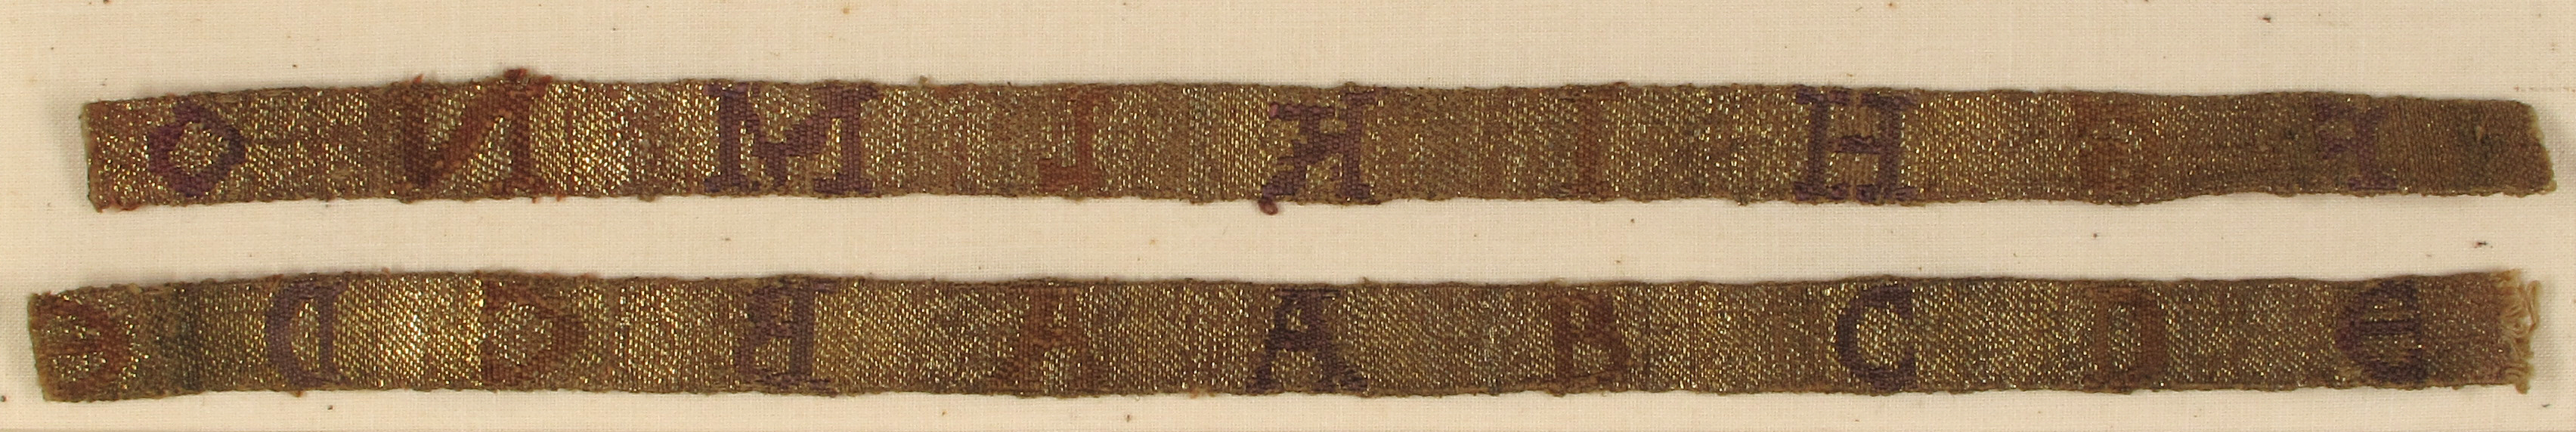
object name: textile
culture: european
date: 1201-1300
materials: metal thread, silk